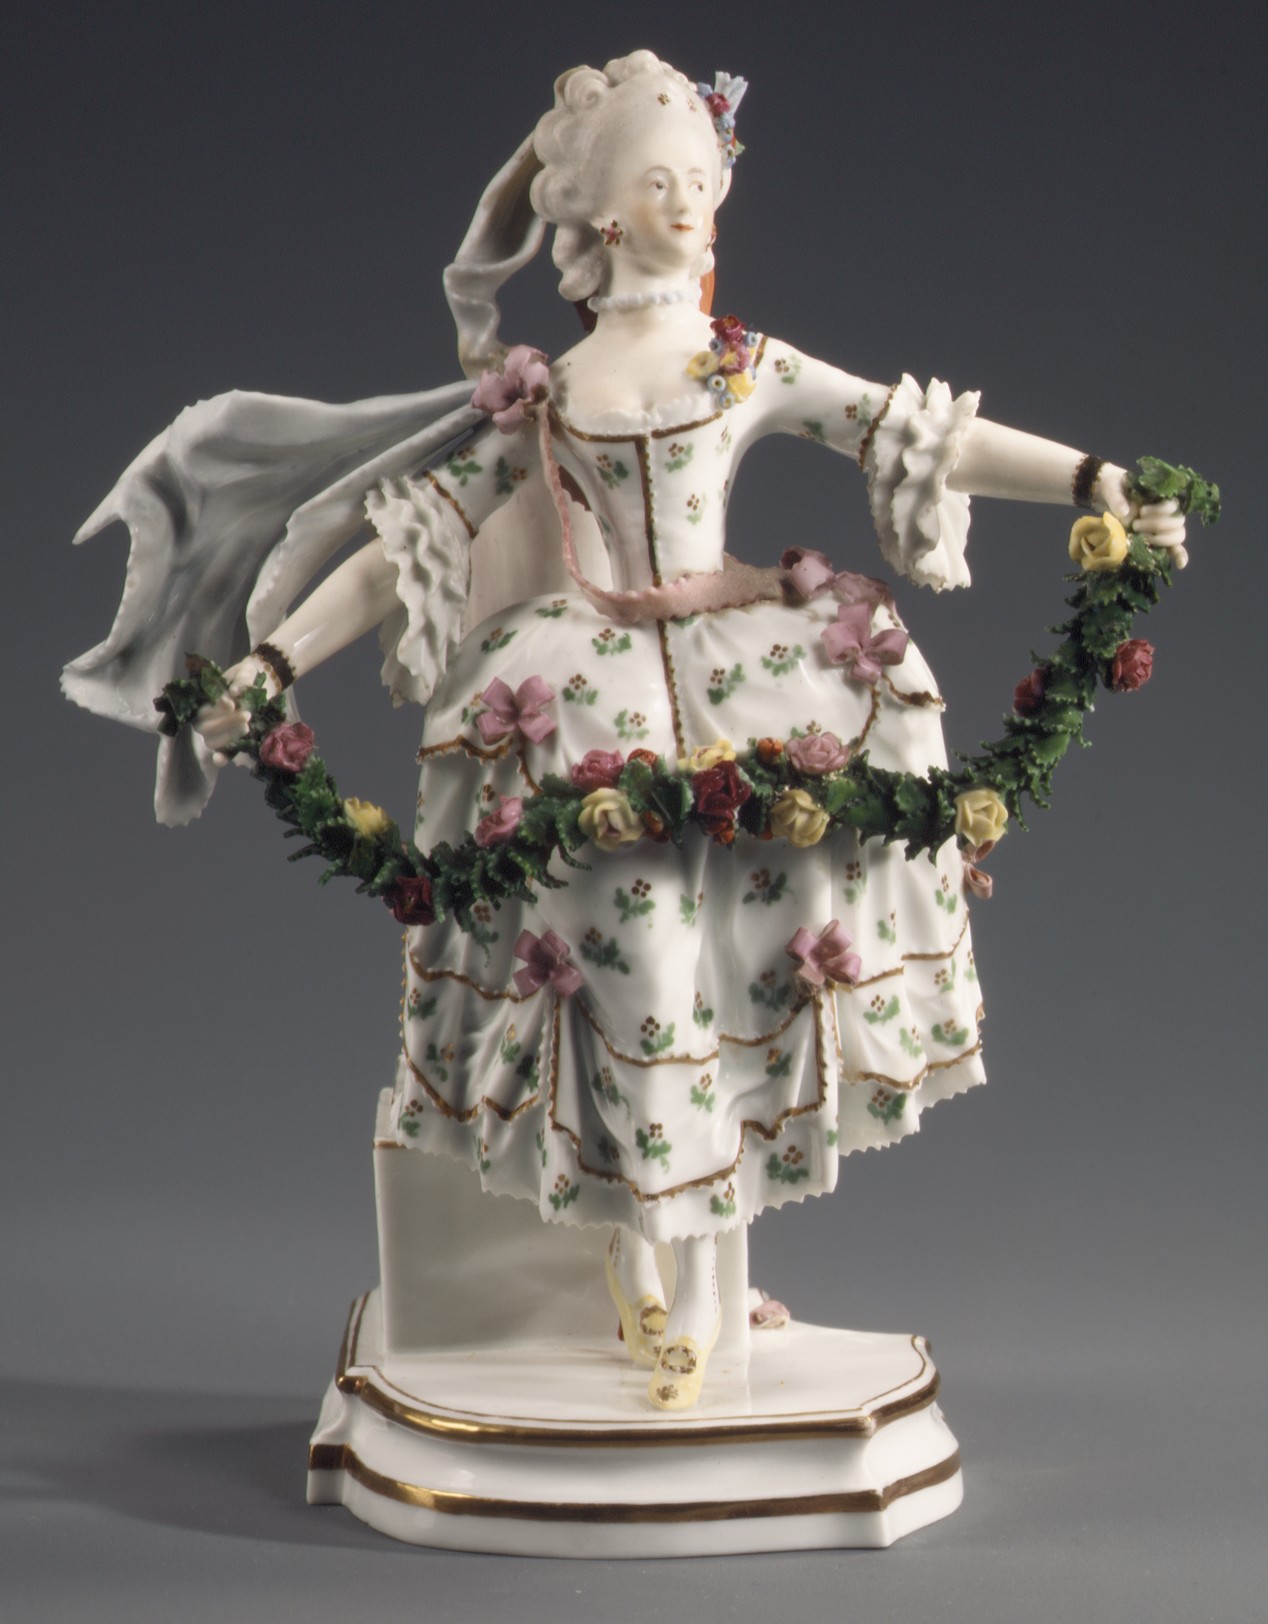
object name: figure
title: Dancer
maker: fulda pottery and porcelain manufactory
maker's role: manufactory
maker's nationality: german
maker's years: 1764-1789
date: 1785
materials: hard paste porcelain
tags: garlands,flowers,dancers